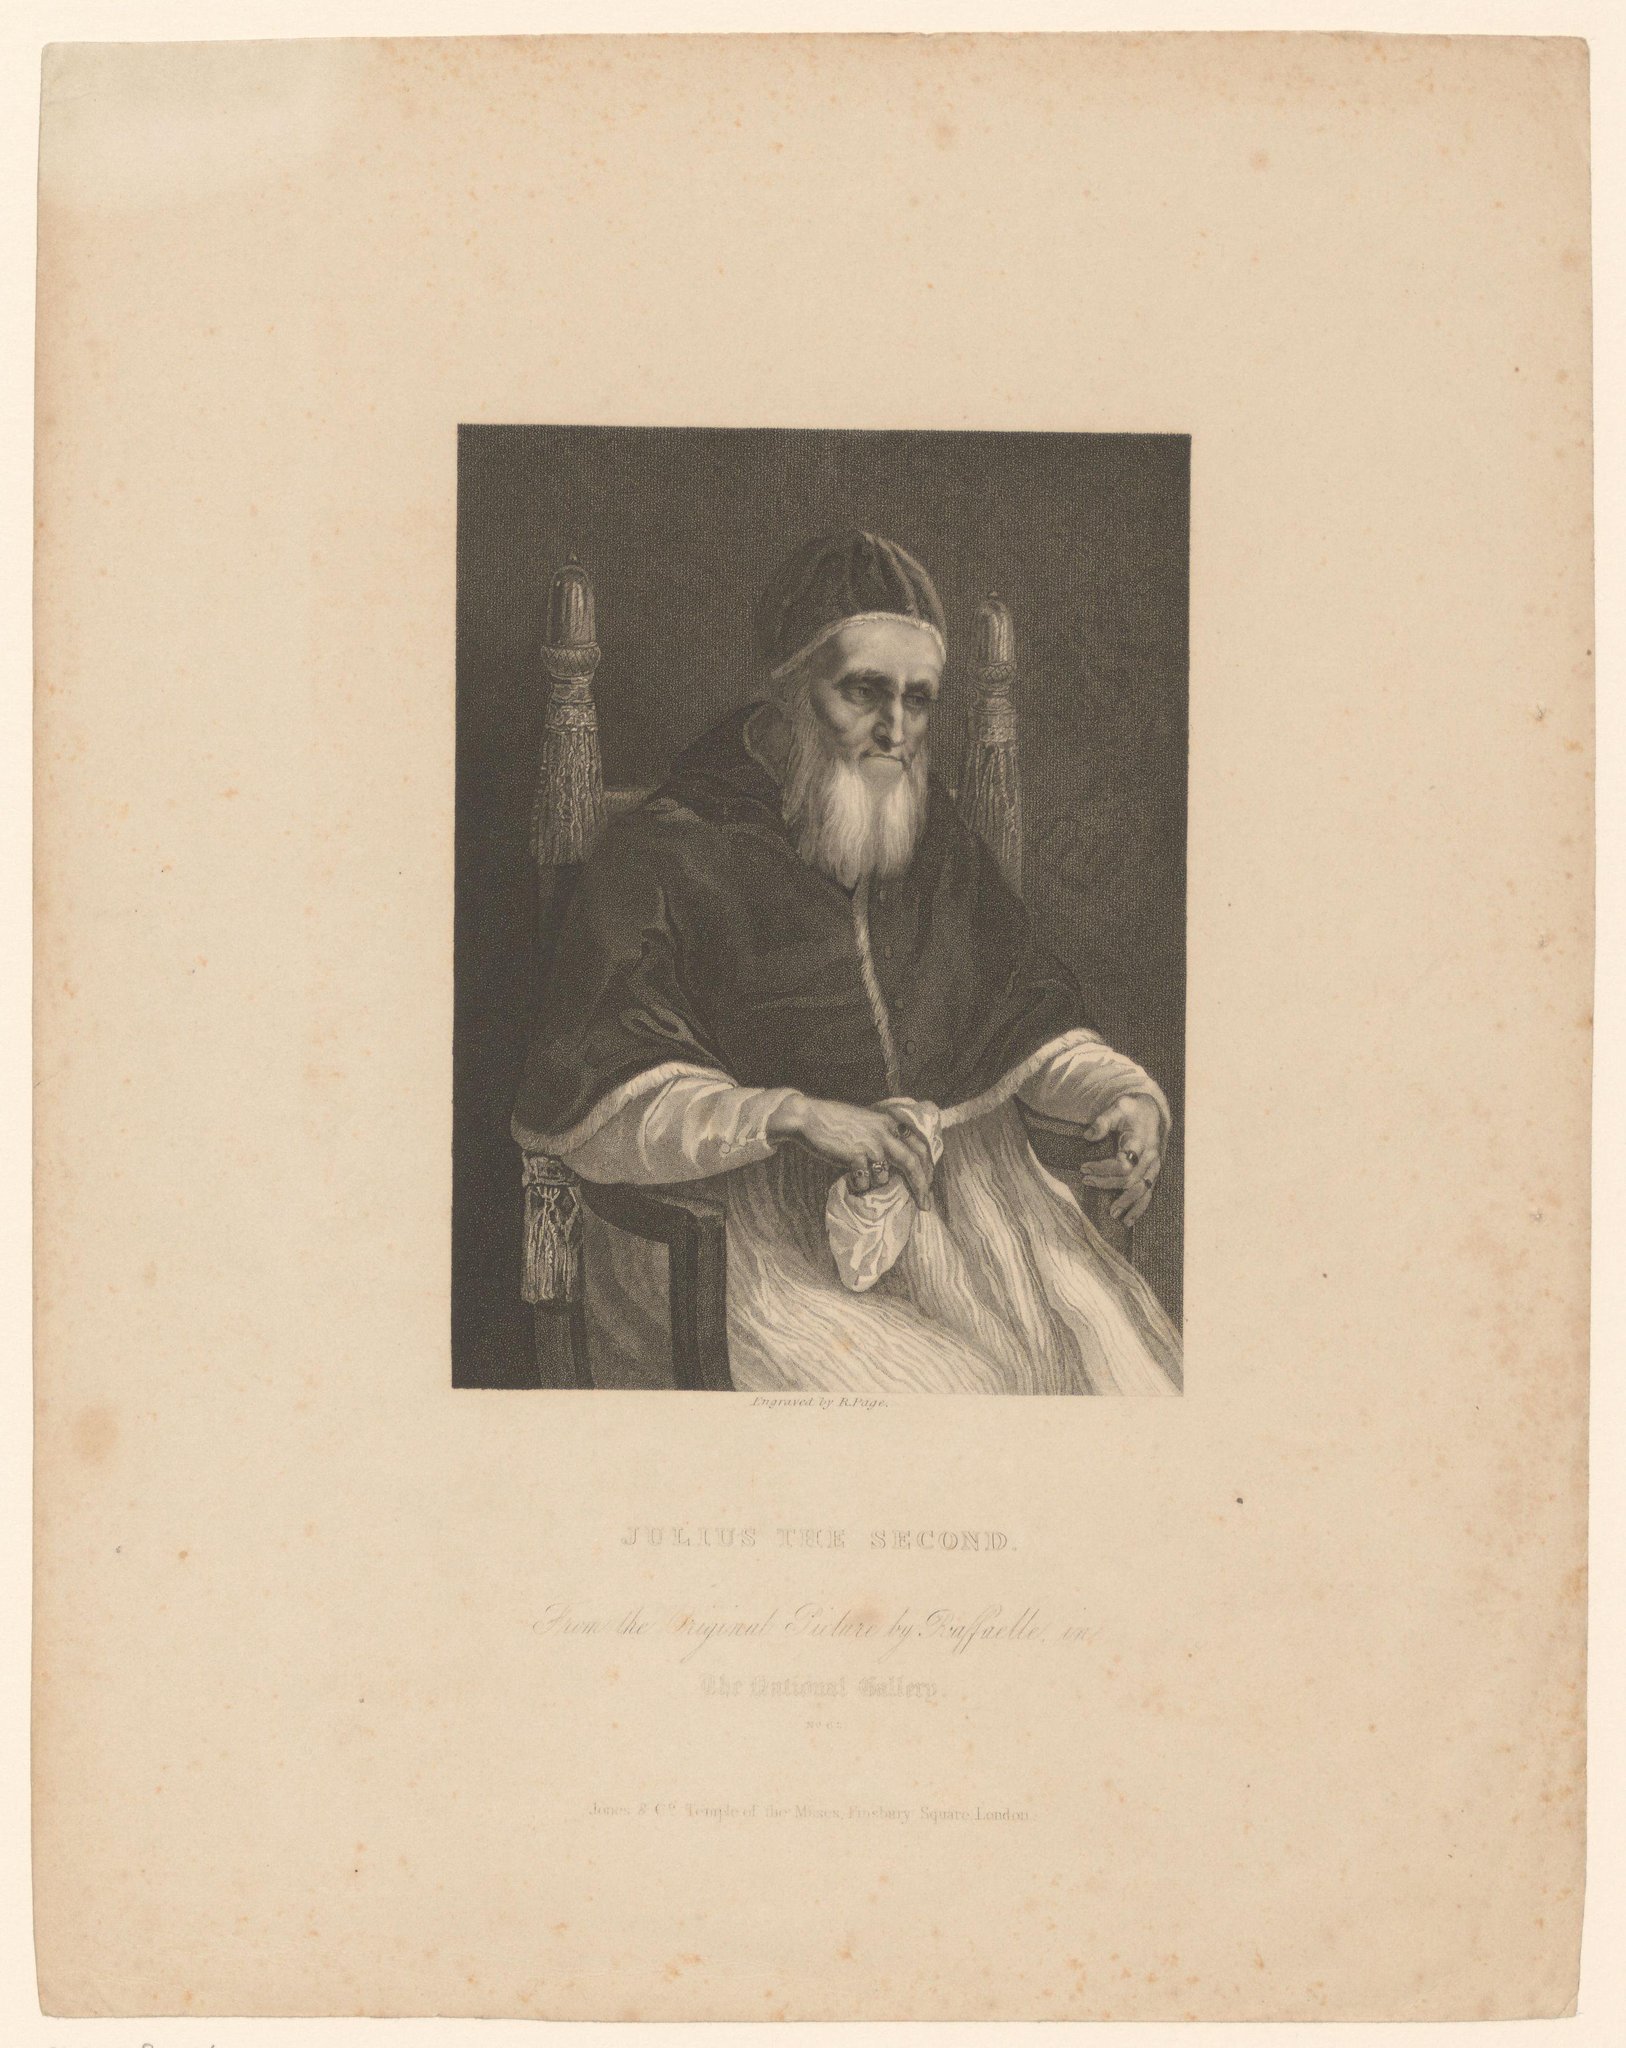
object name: book illustration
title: Portret van Julius II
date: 1836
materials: paper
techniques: stippling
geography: london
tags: rome, historical persons, pope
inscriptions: collector's mark: Lugt 2228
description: Prent uit: The National Gallery of Pictures by the Great Masters (...). Londen: Jones & Co, 1836.